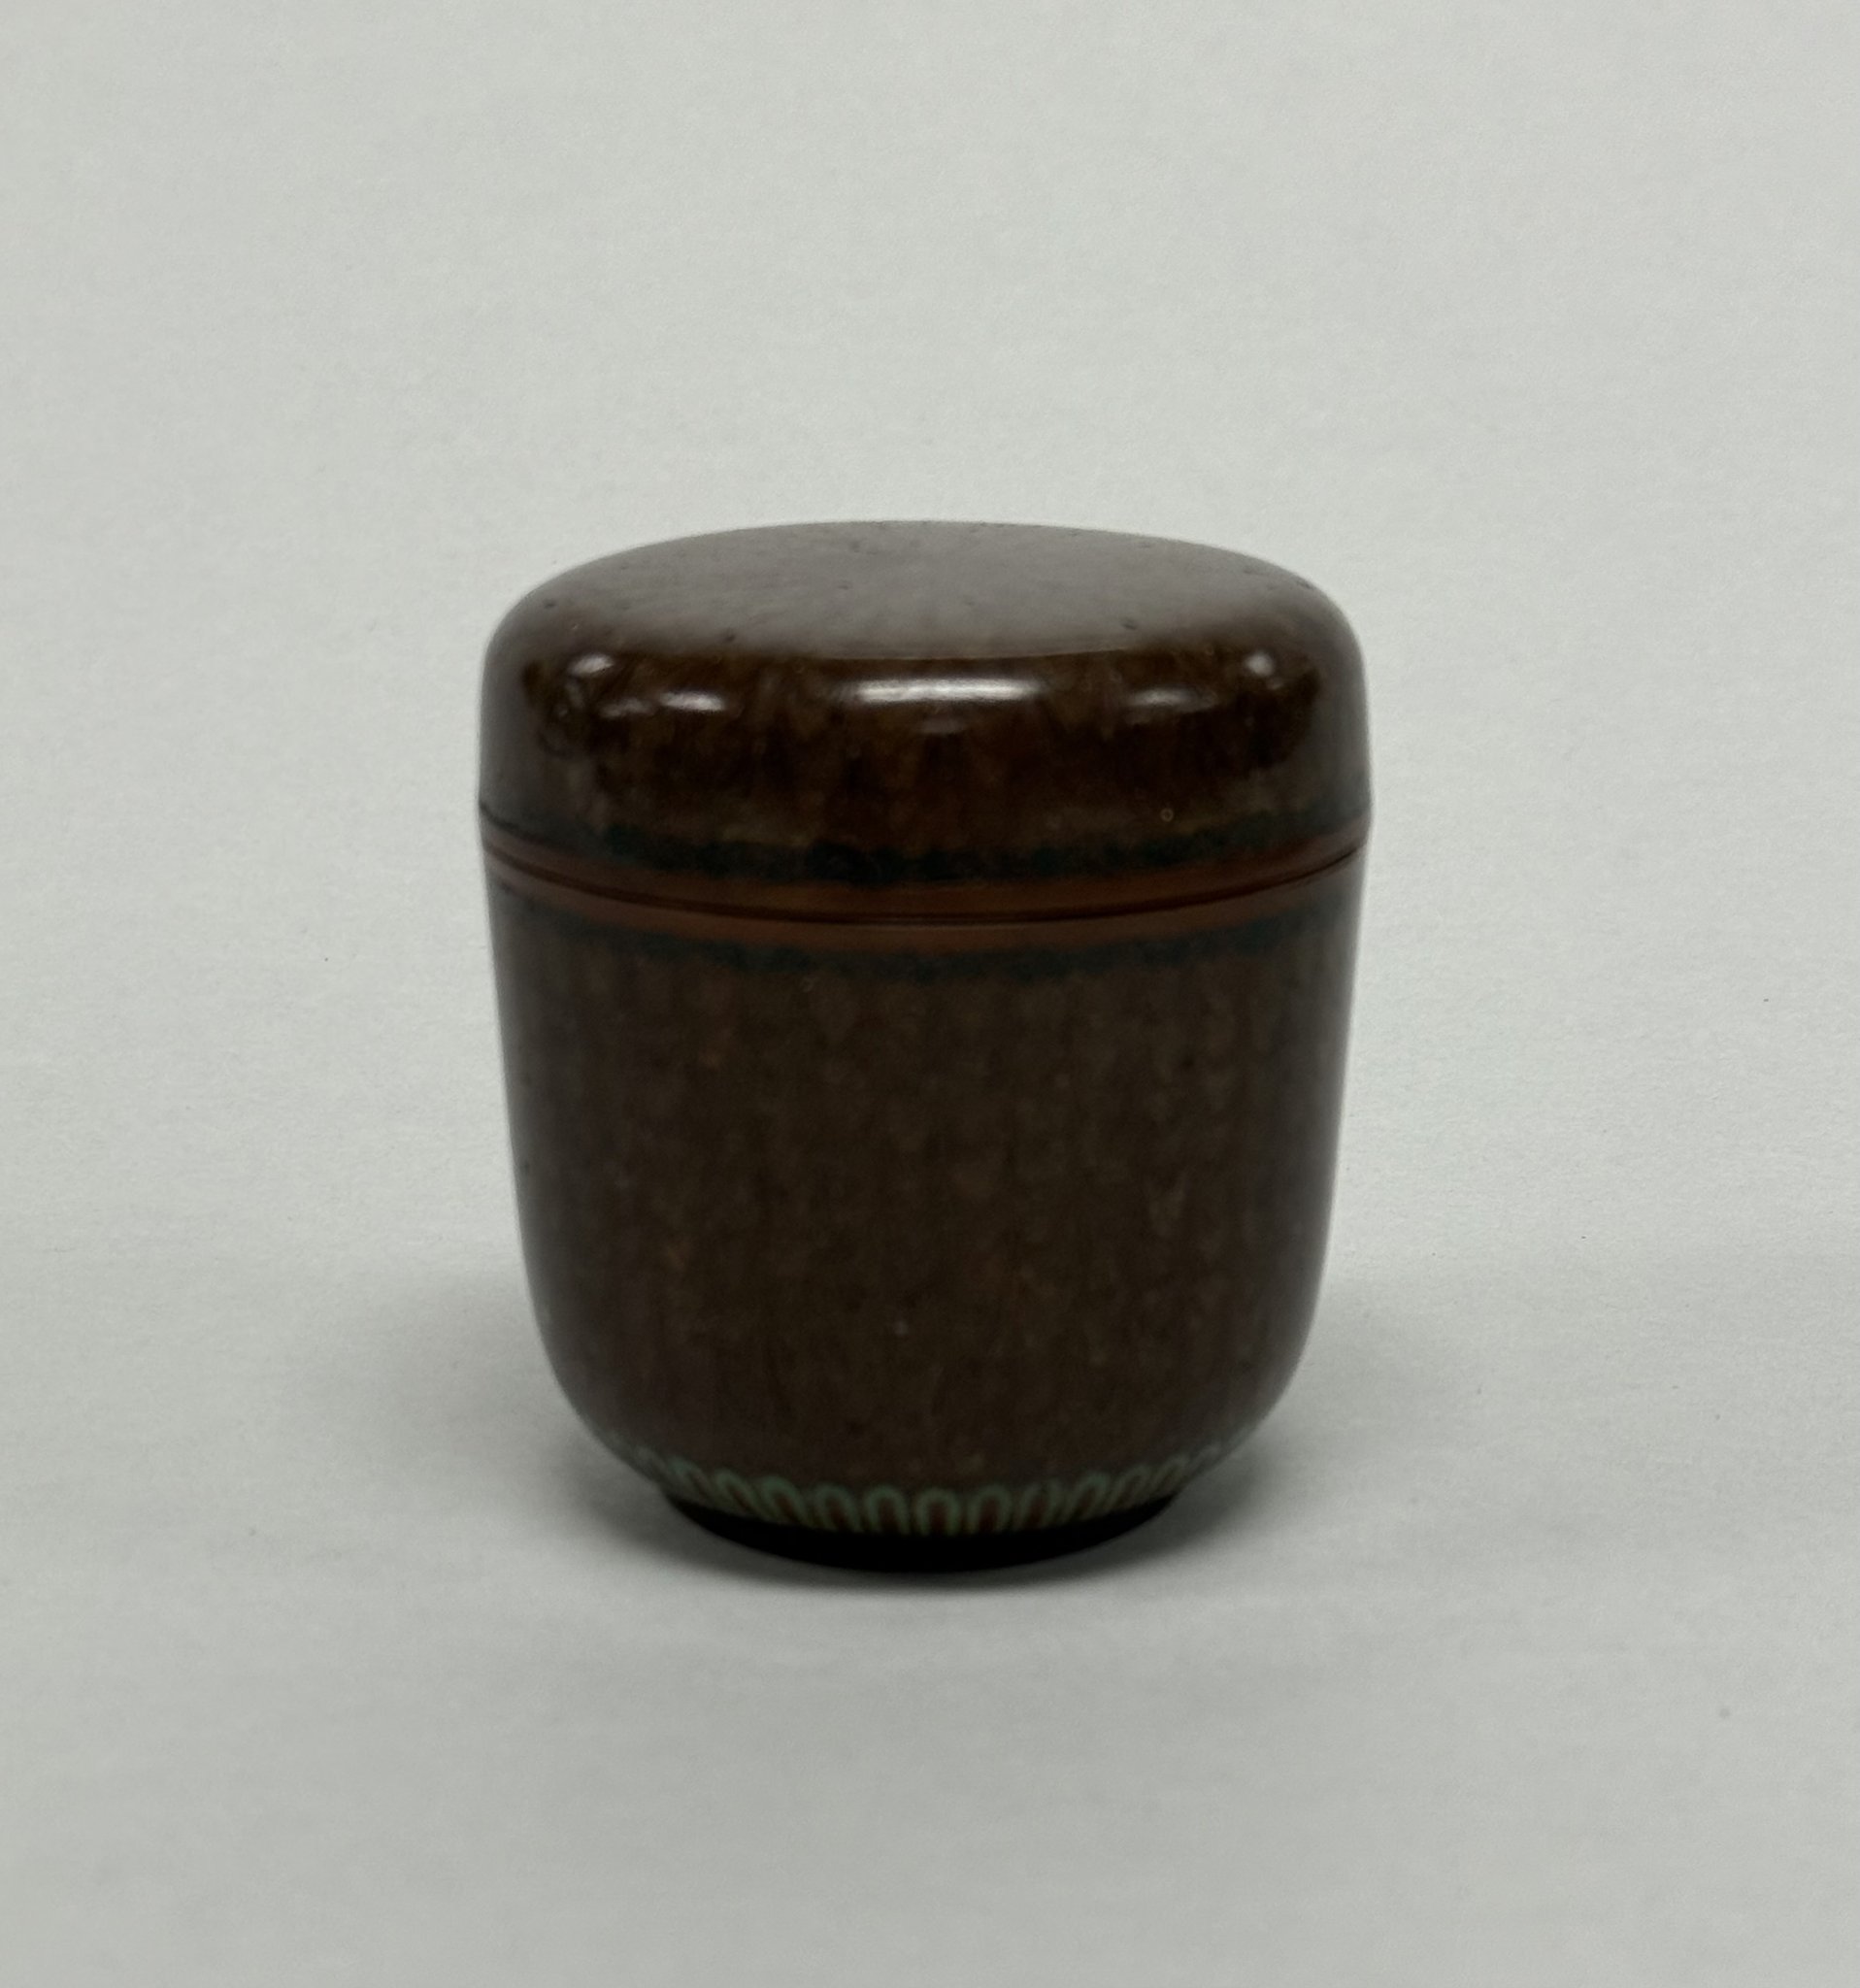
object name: box with cover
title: Box and Cover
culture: japanese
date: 1801-1900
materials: bronze